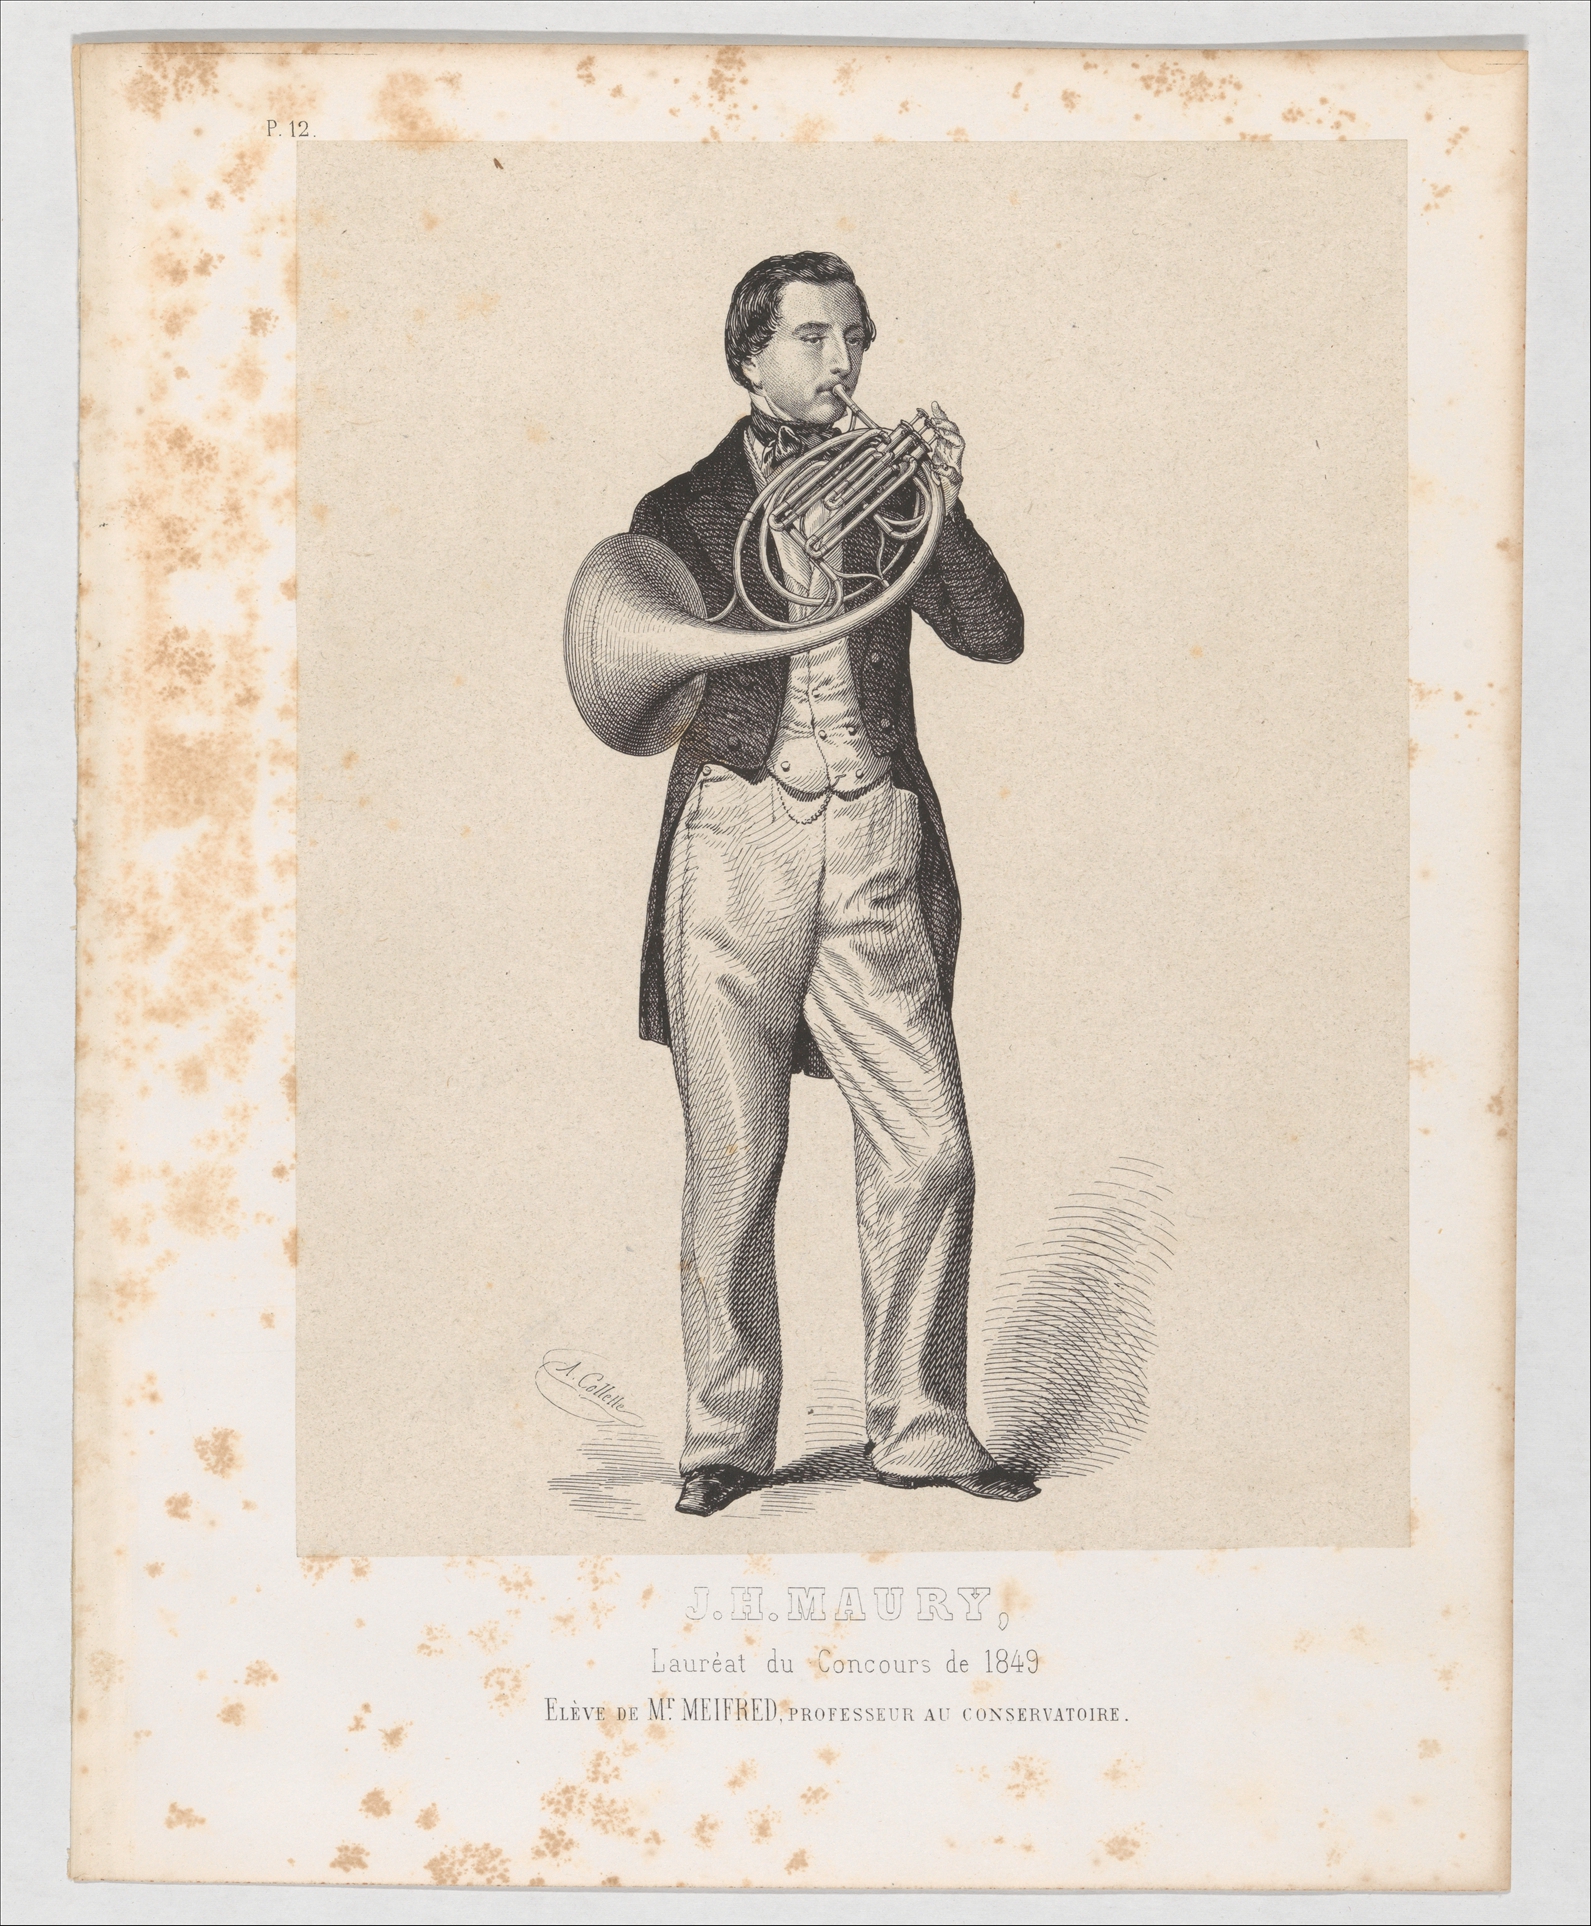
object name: lithographic plate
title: Lithographic Plates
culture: french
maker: alexandre désiré collette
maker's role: print maker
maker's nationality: french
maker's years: 1814-1876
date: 1850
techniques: lithograph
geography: france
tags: musical instruments,men,musicians